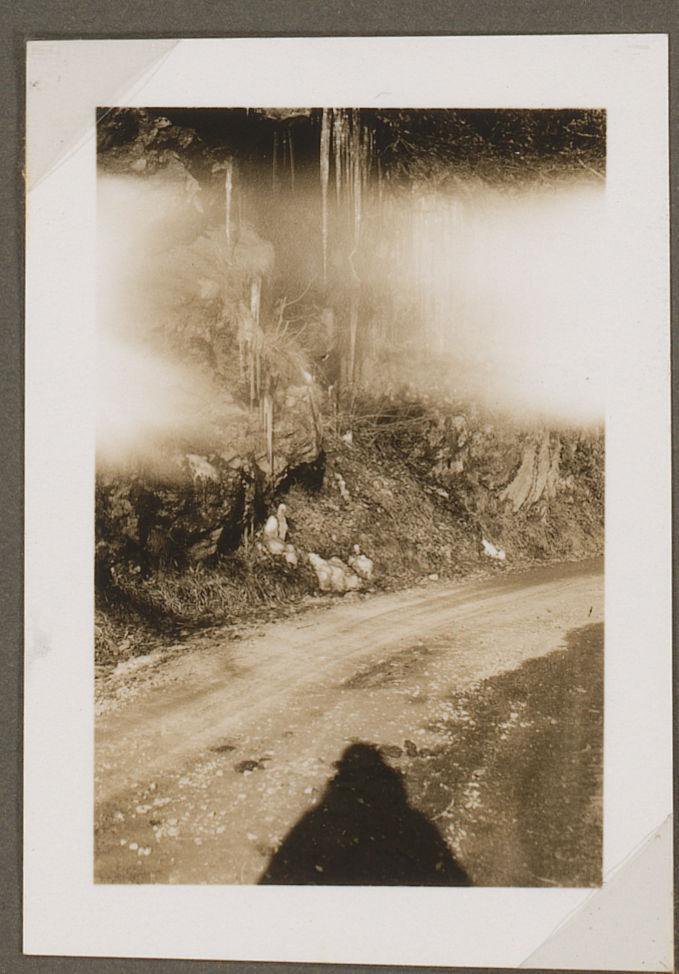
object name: album leaf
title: IJskegels langs een weg bij Oggio, Zwitserland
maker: Anonymous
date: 1934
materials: photographic support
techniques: gelatin silver print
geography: capriasca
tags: icicle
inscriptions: number: ‘46’